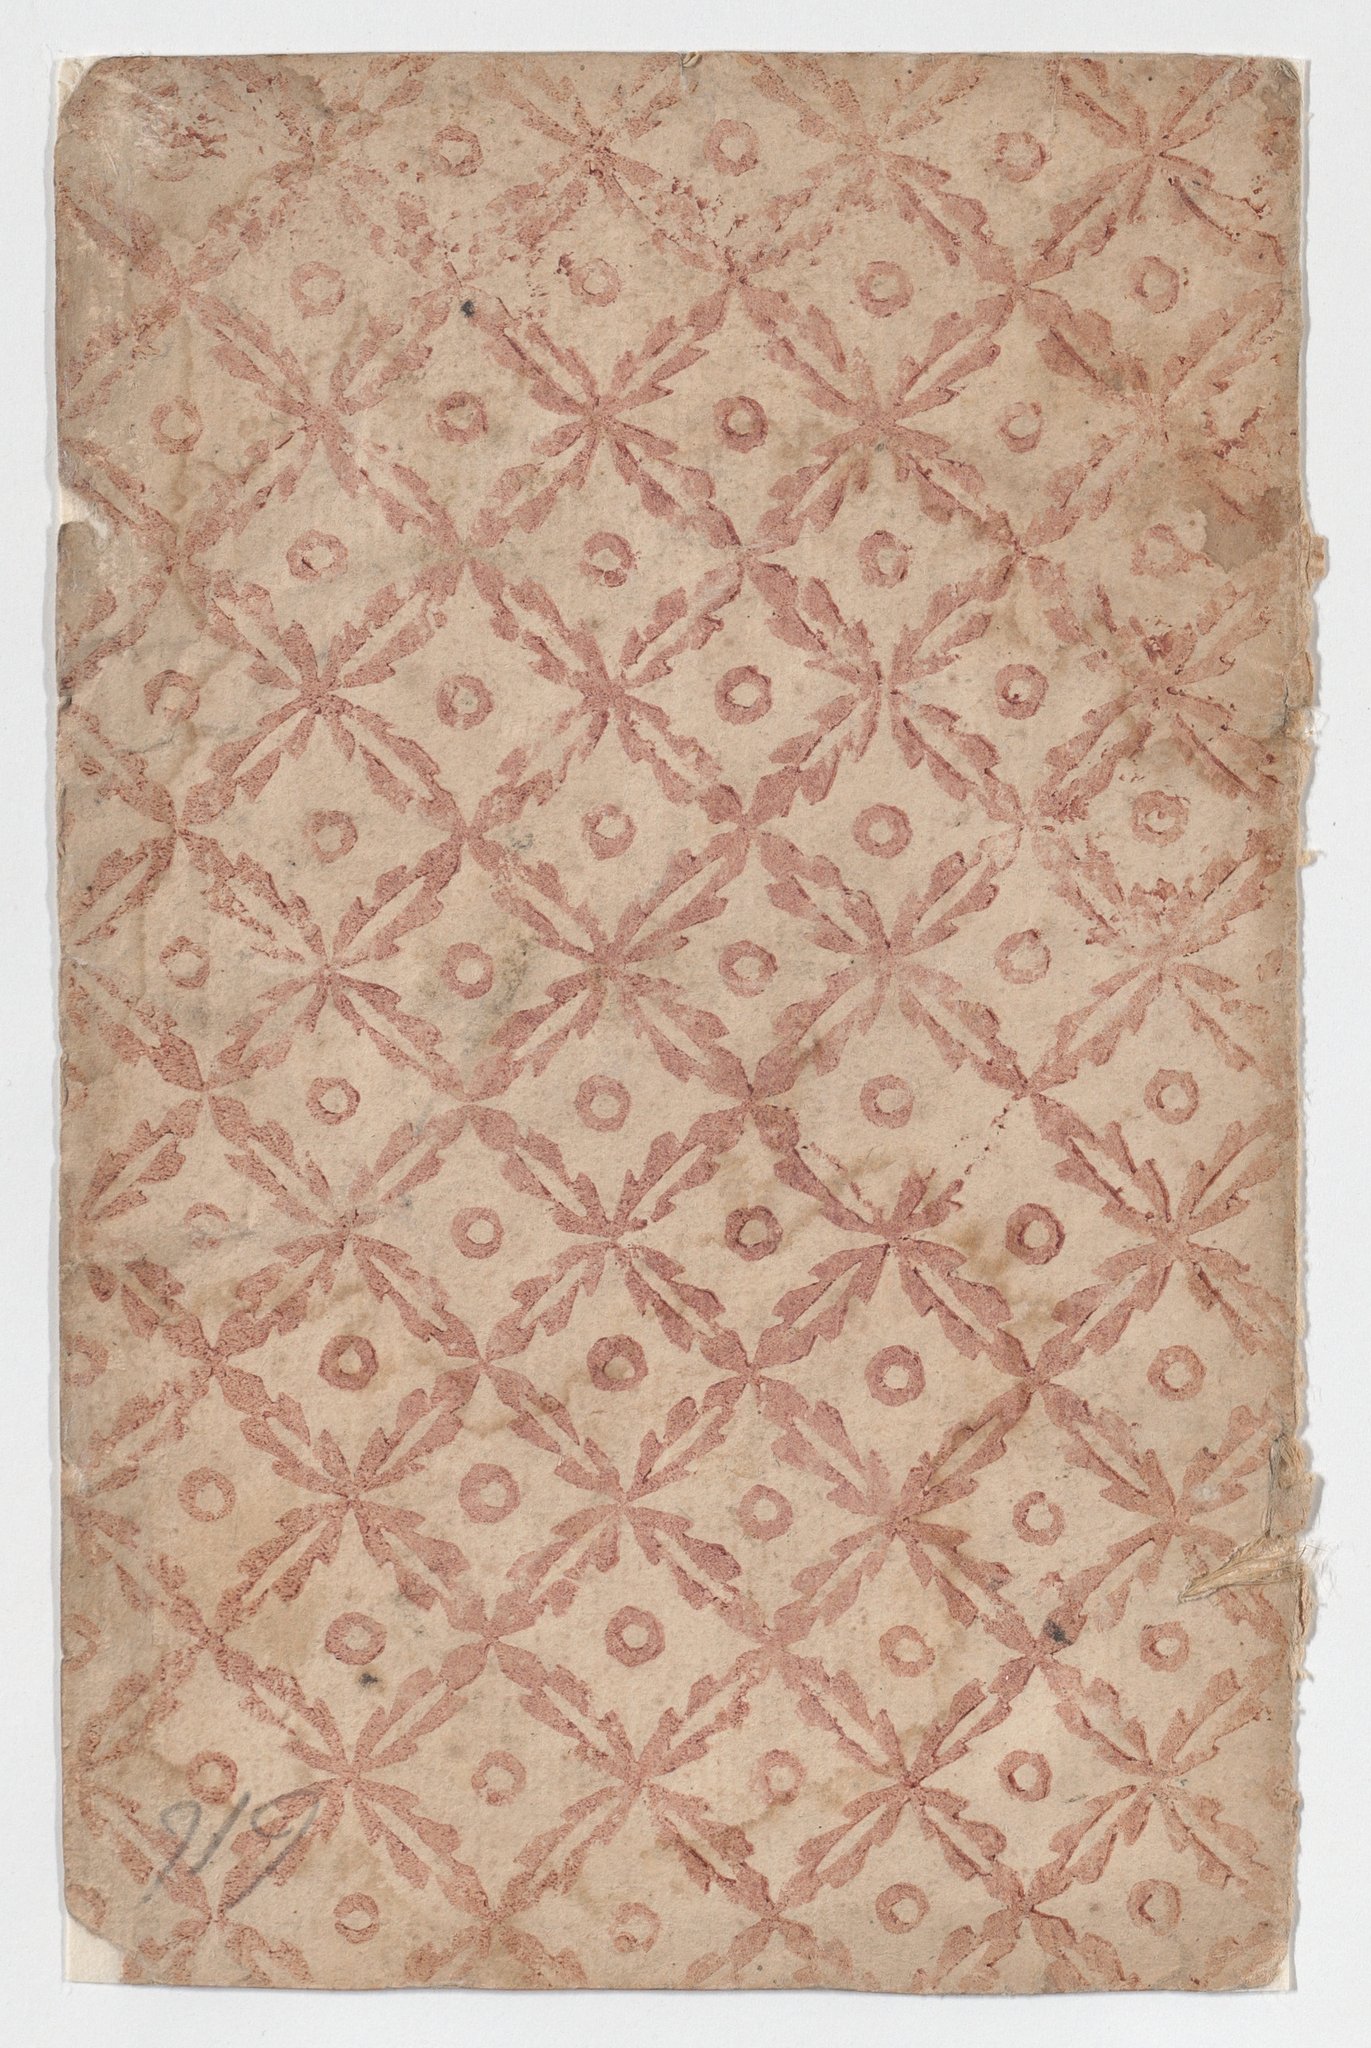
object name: print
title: Sheet with overall pattern of flowers and circles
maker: Anonymous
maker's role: artist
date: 1801-1900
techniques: relief print